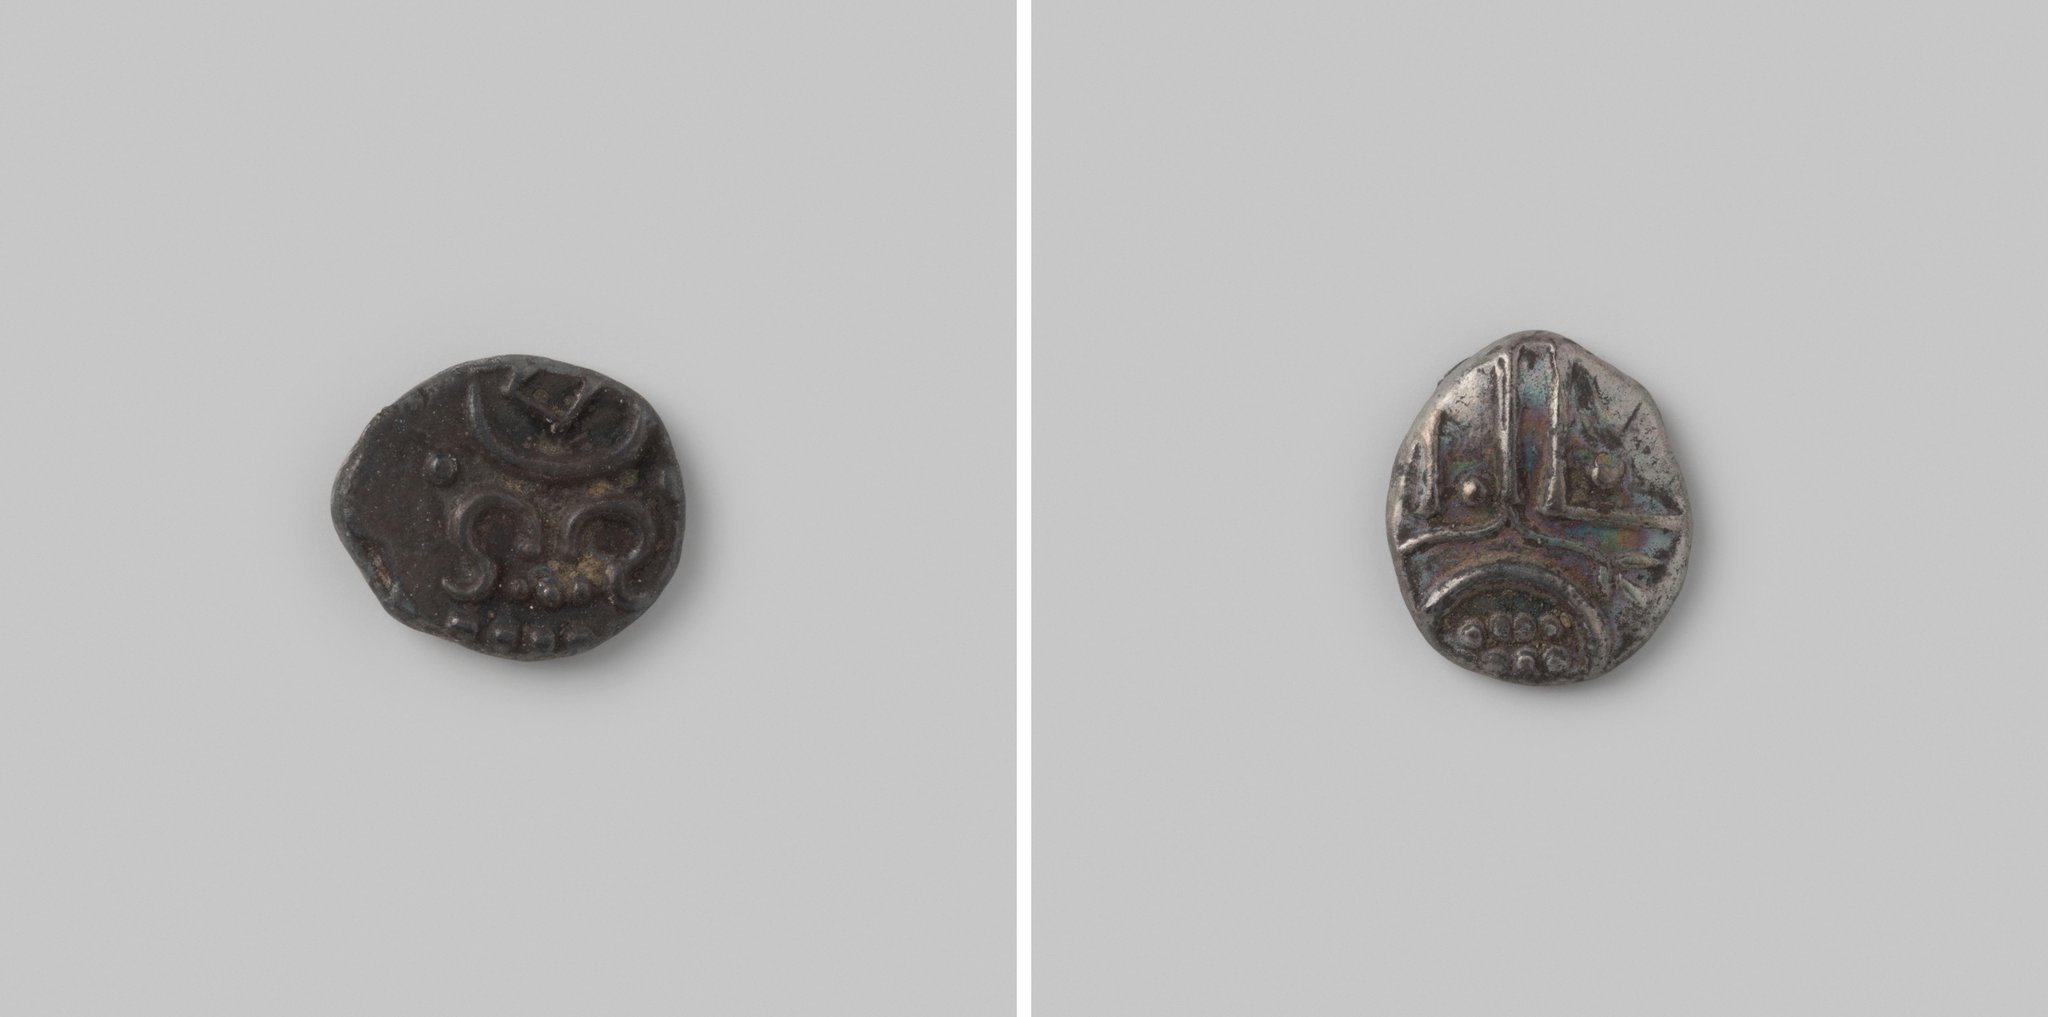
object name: coin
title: Zilveren vira raya fanam uit Travancore in India,1600-1800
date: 1600-1800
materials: silver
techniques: striking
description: Zilveren munt. Voorzijde: "vira raya"-afbeelding met de stippen boven de tekens. Keerzijde: "vira raya"-afbeelding met de stippen onder de tekens.